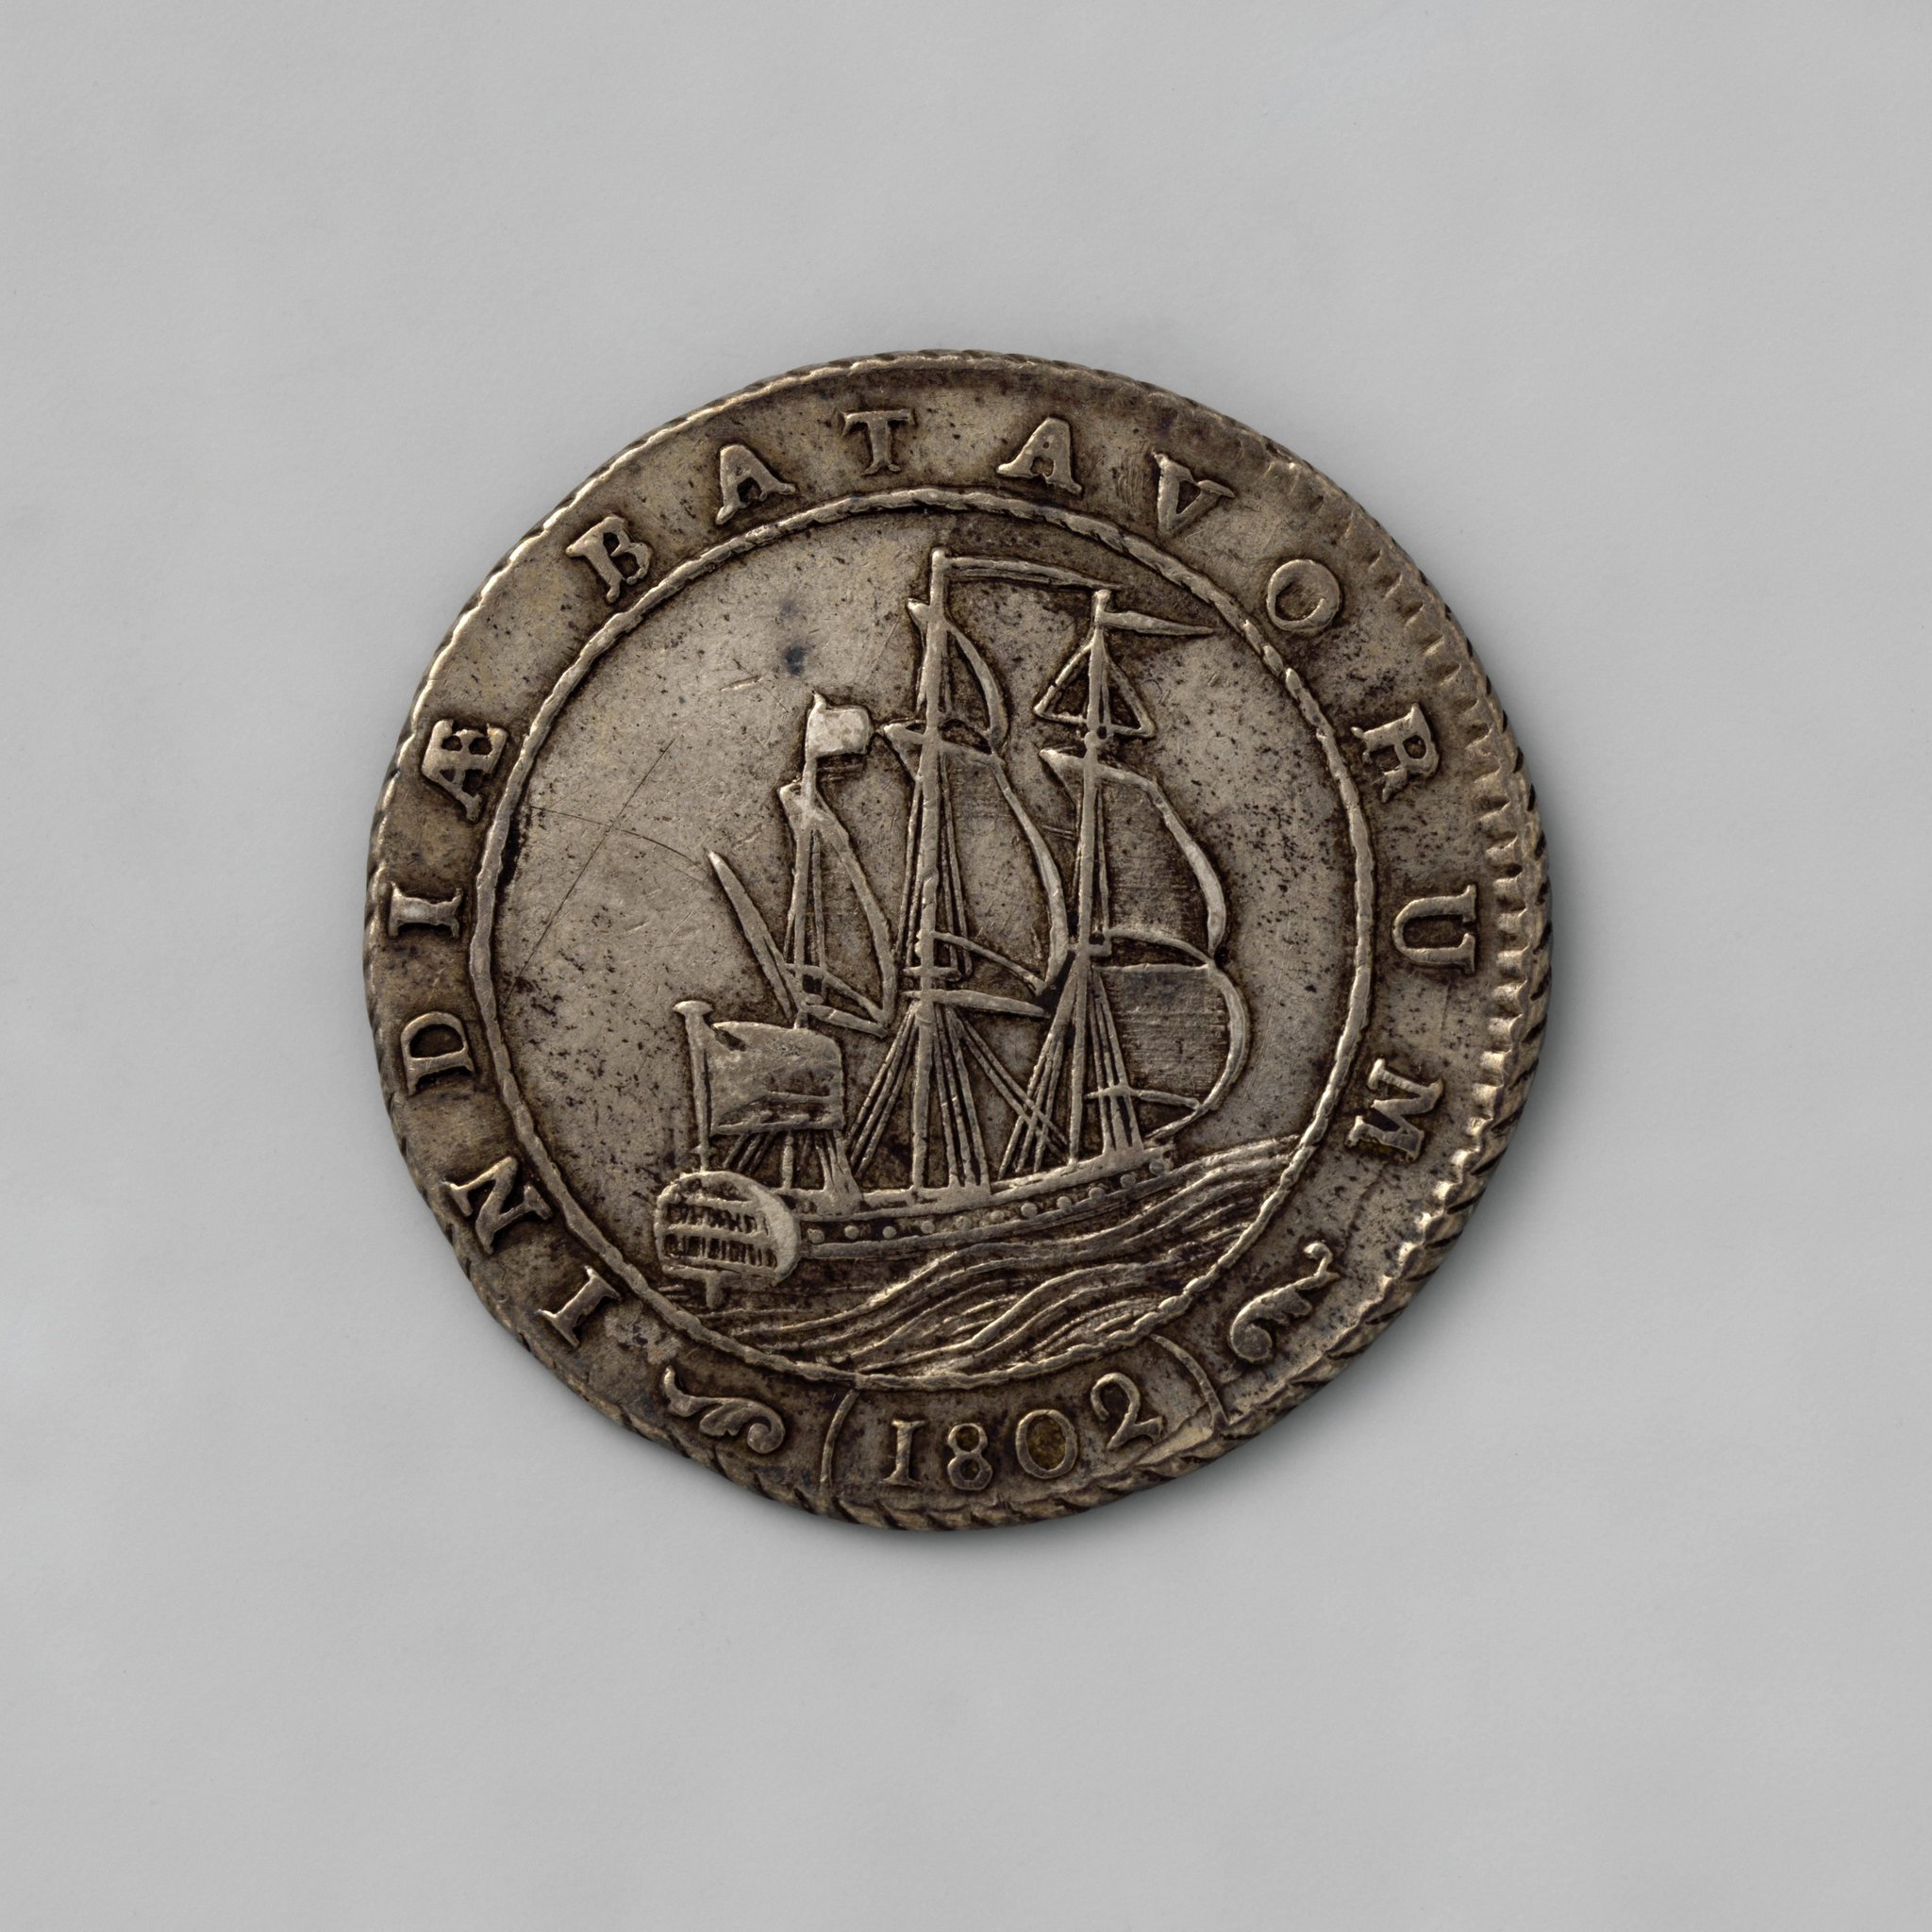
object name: coin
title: Gulden voor Nederlands Indië, 1802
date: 1802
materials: silver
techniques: striking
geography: enkhuizen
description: Zilveren munt. Voorzijde: Driemaster met volle zeilen op open zee. Versierd jaartal onderaan in omschrift. Keerzijde: tussen waarde-aanduiding I G gekroond generaliteitswapenschild. Muntteken boven kroon in omschrift. Kabelrand.